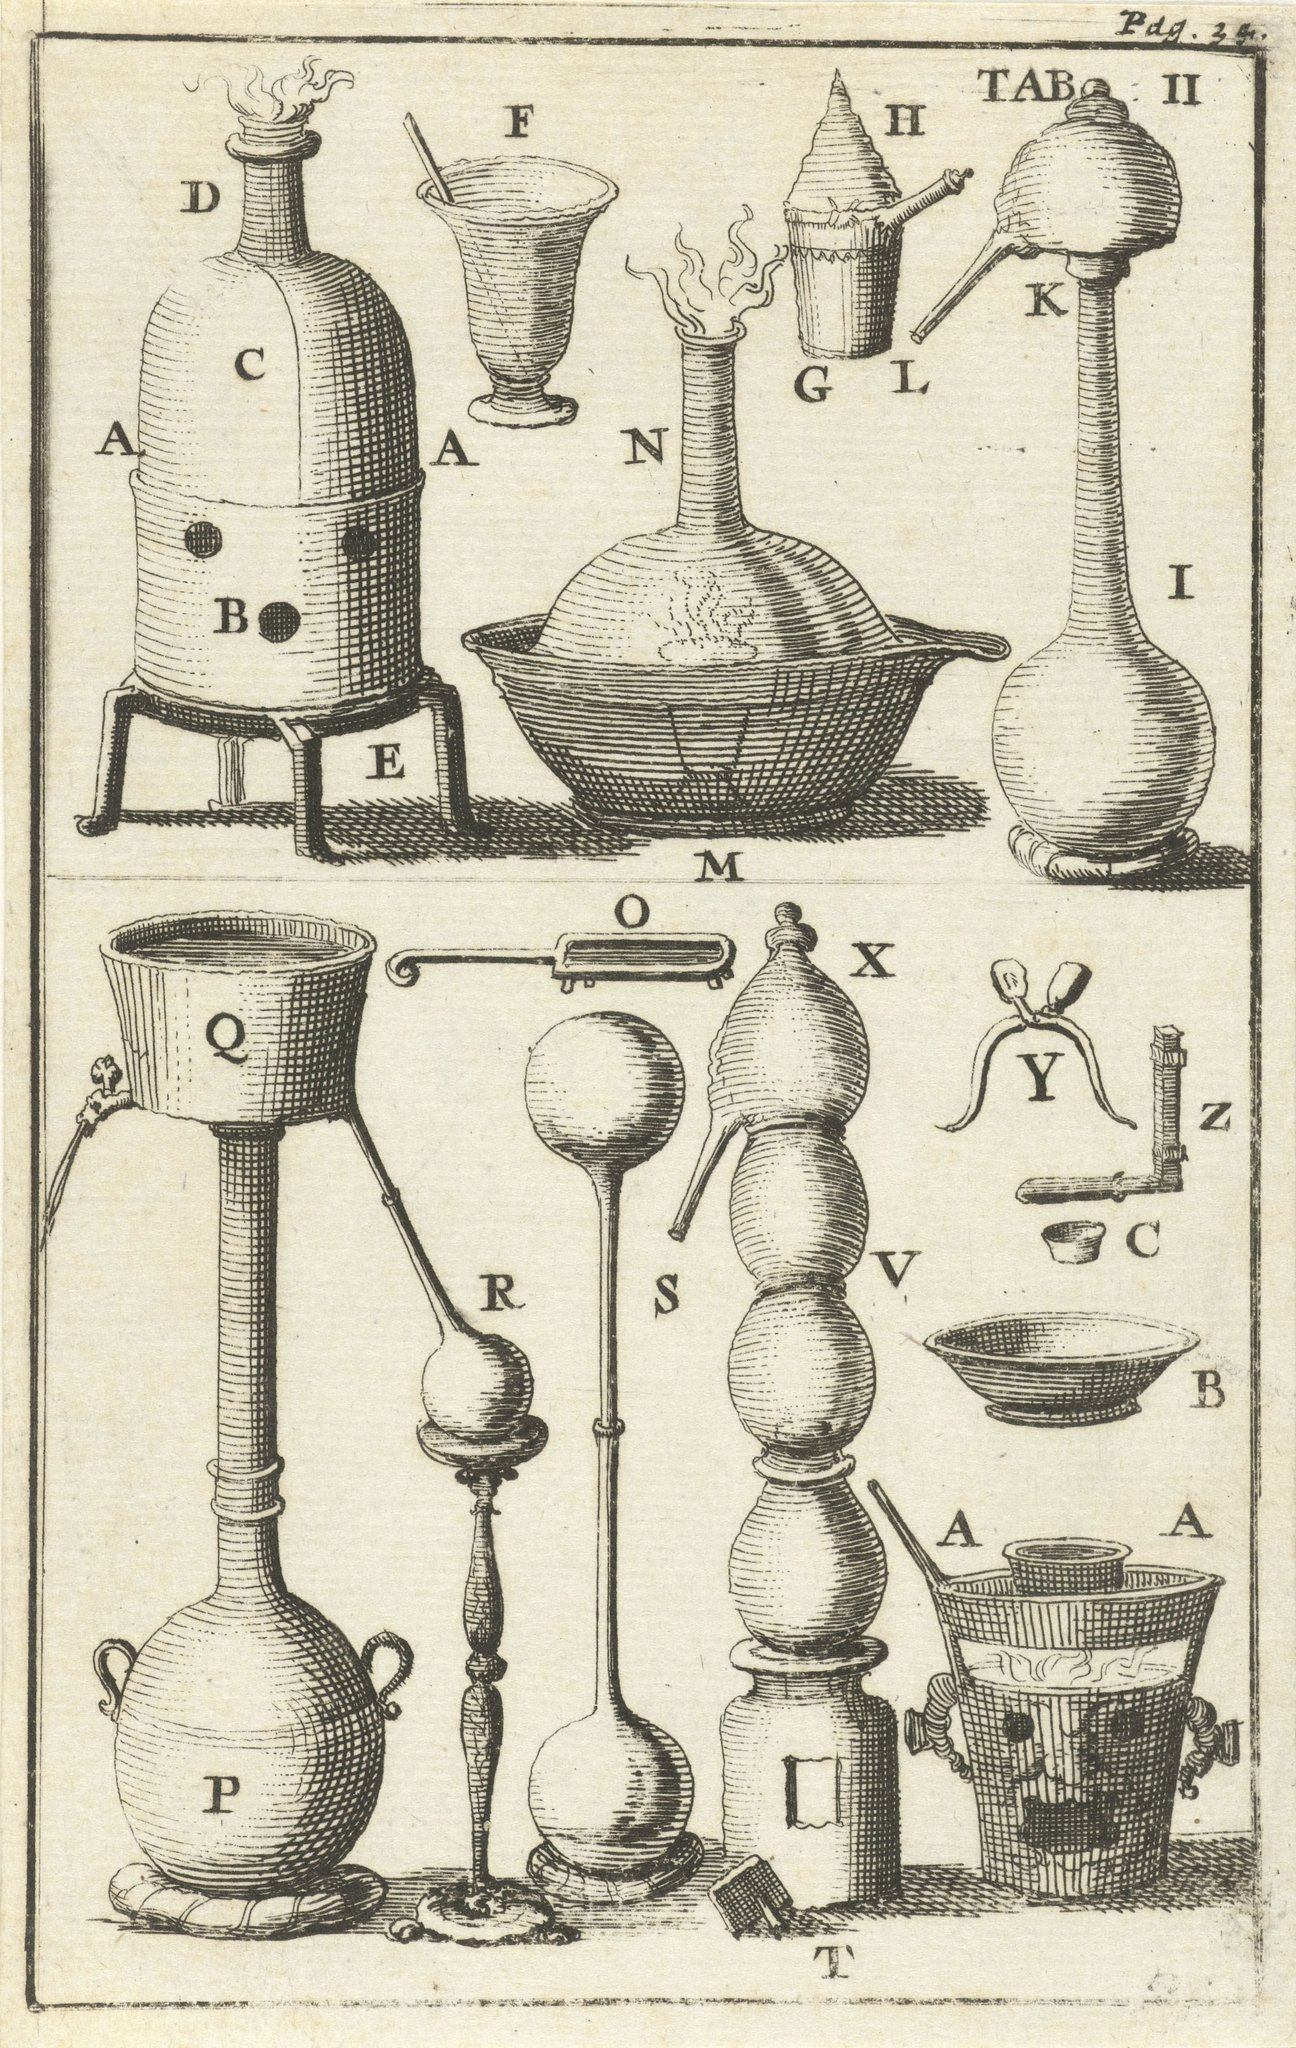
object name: print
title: Verschillende retorten A-CC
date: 1683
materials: paper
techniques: etching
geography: amsterdam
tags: laboratory (+ tools, instruments; laboratory equipment ~ scientific research)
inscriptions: collector's mark: Lugt 2228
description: Illustratie opgenomen in: L'Emery, Nicolas. Het philosoophische laboratorium, of der chymisten stook-huis. Amsterdam: Jan Claesz ten Hoorn, 1683, p. 34.